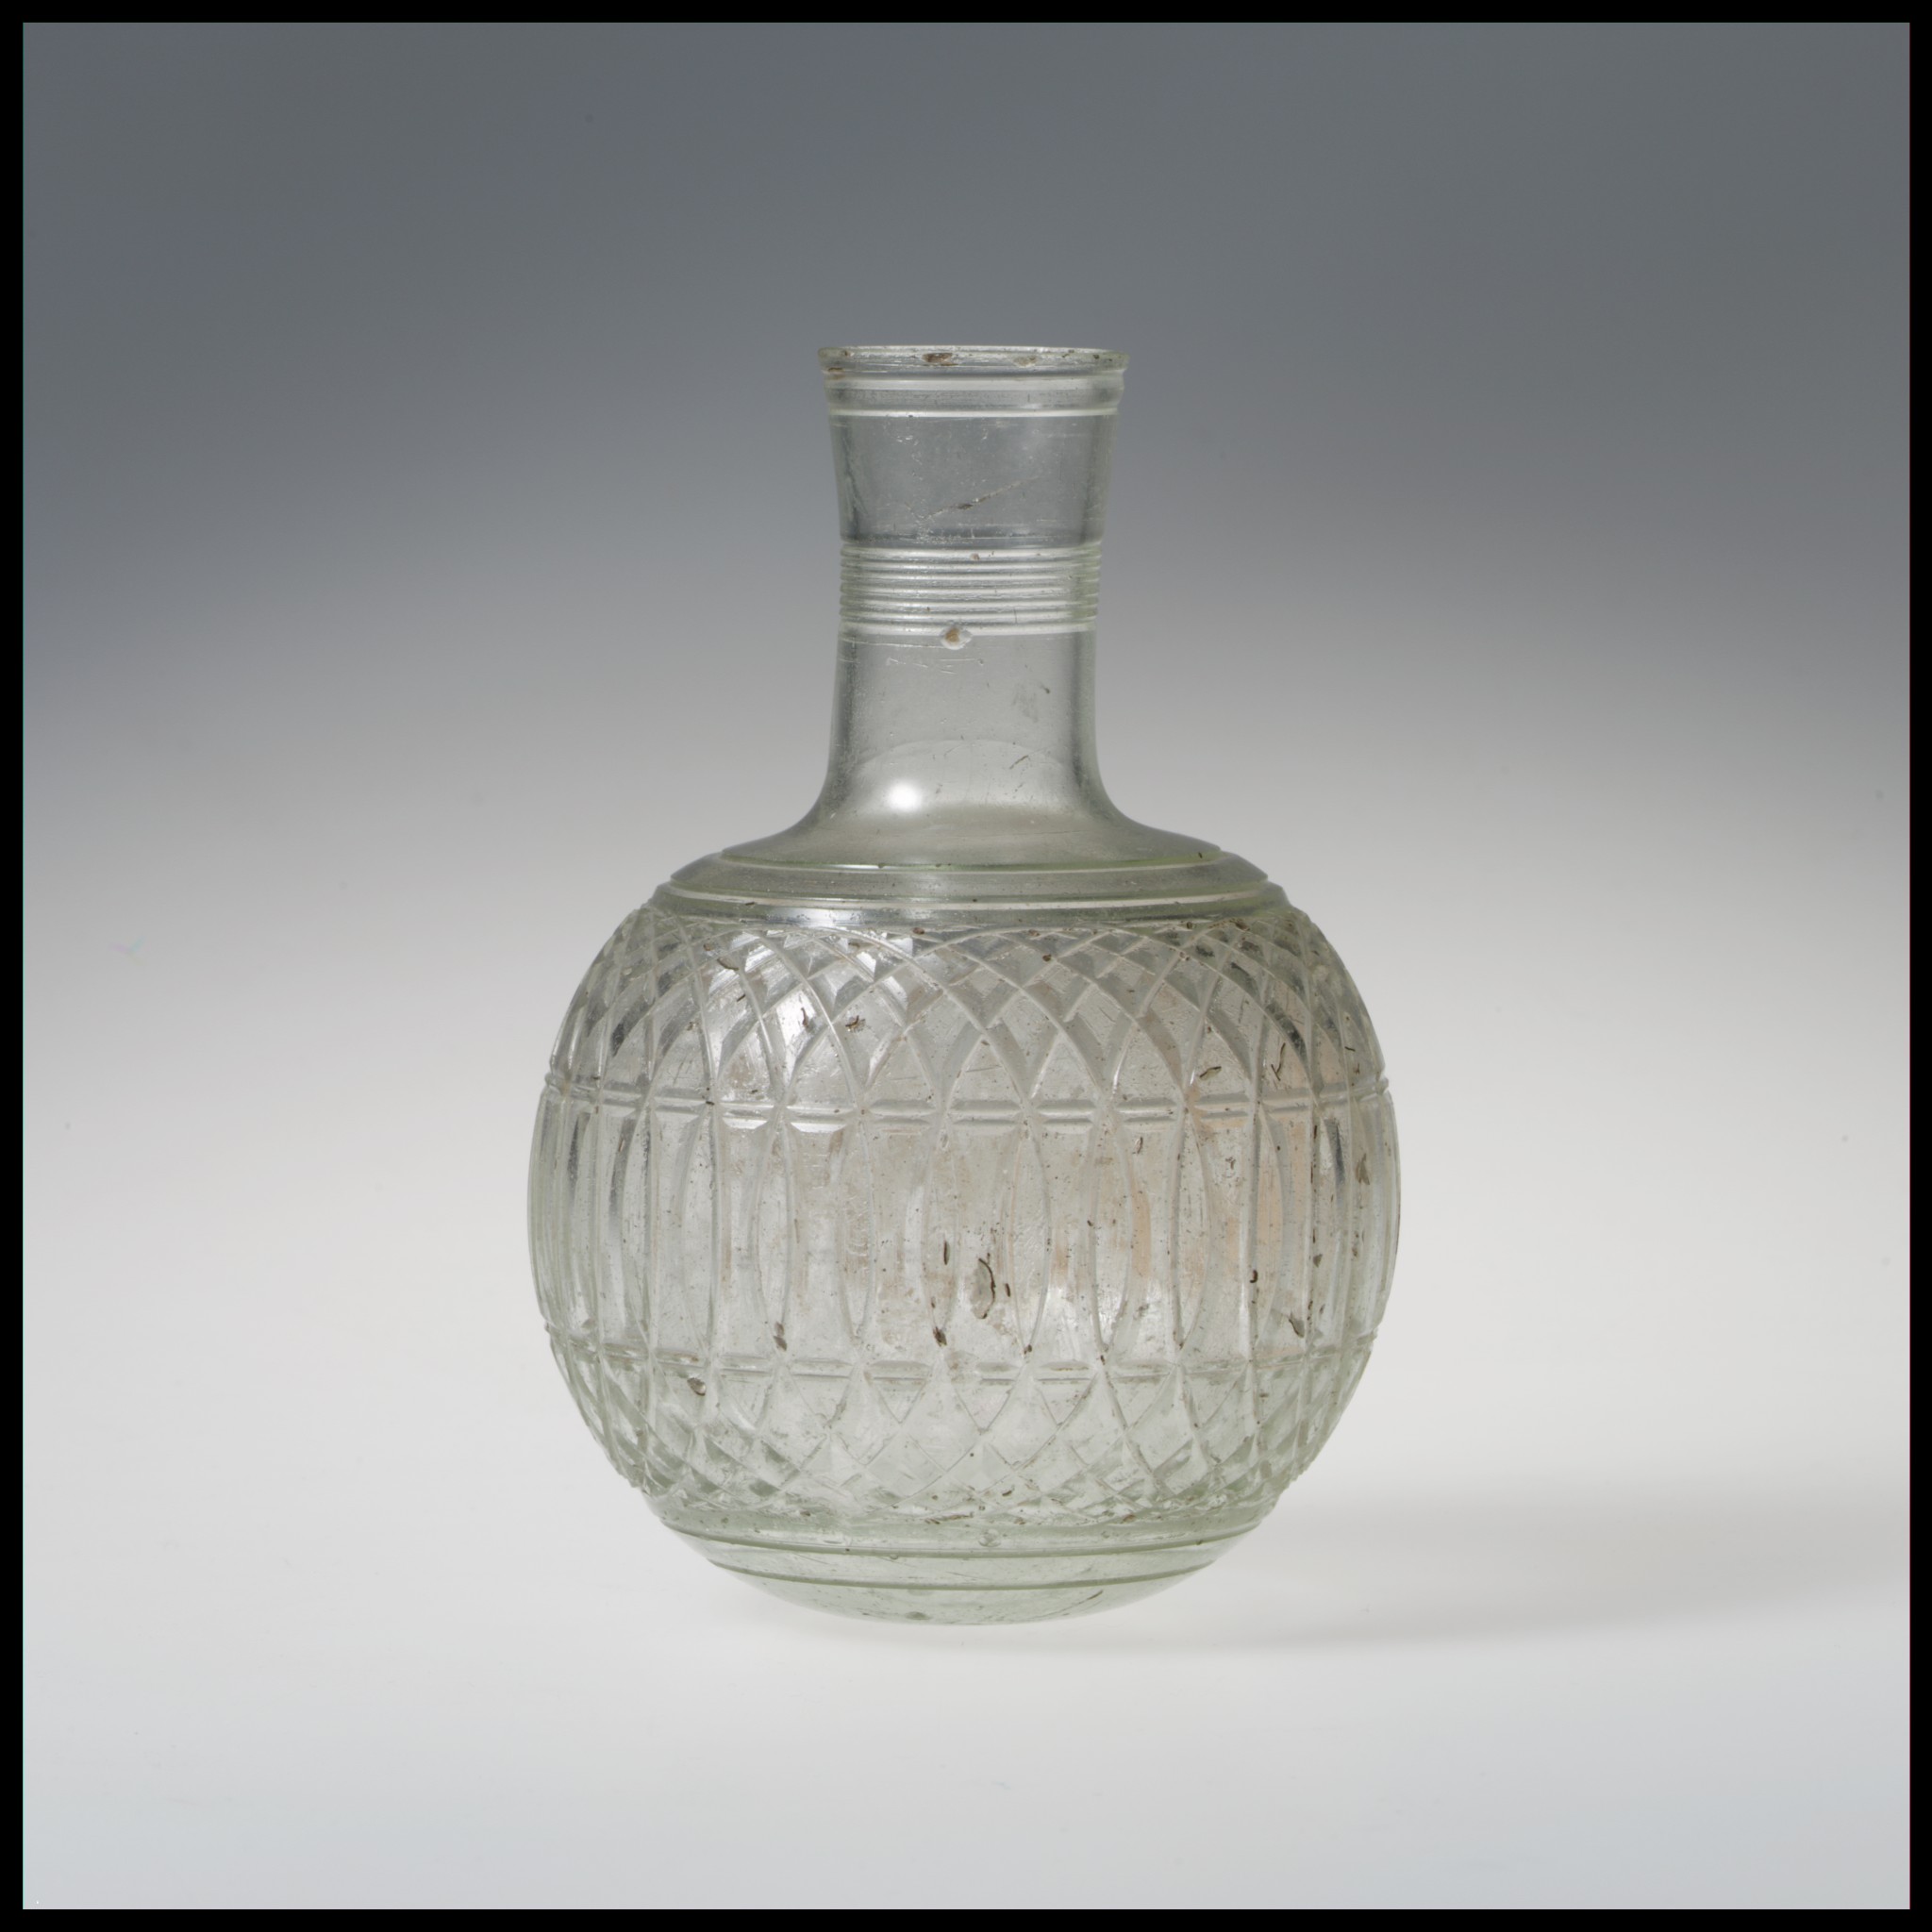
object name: bottle, globular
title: Glass globular bottle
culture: roman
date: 201-400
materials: glass